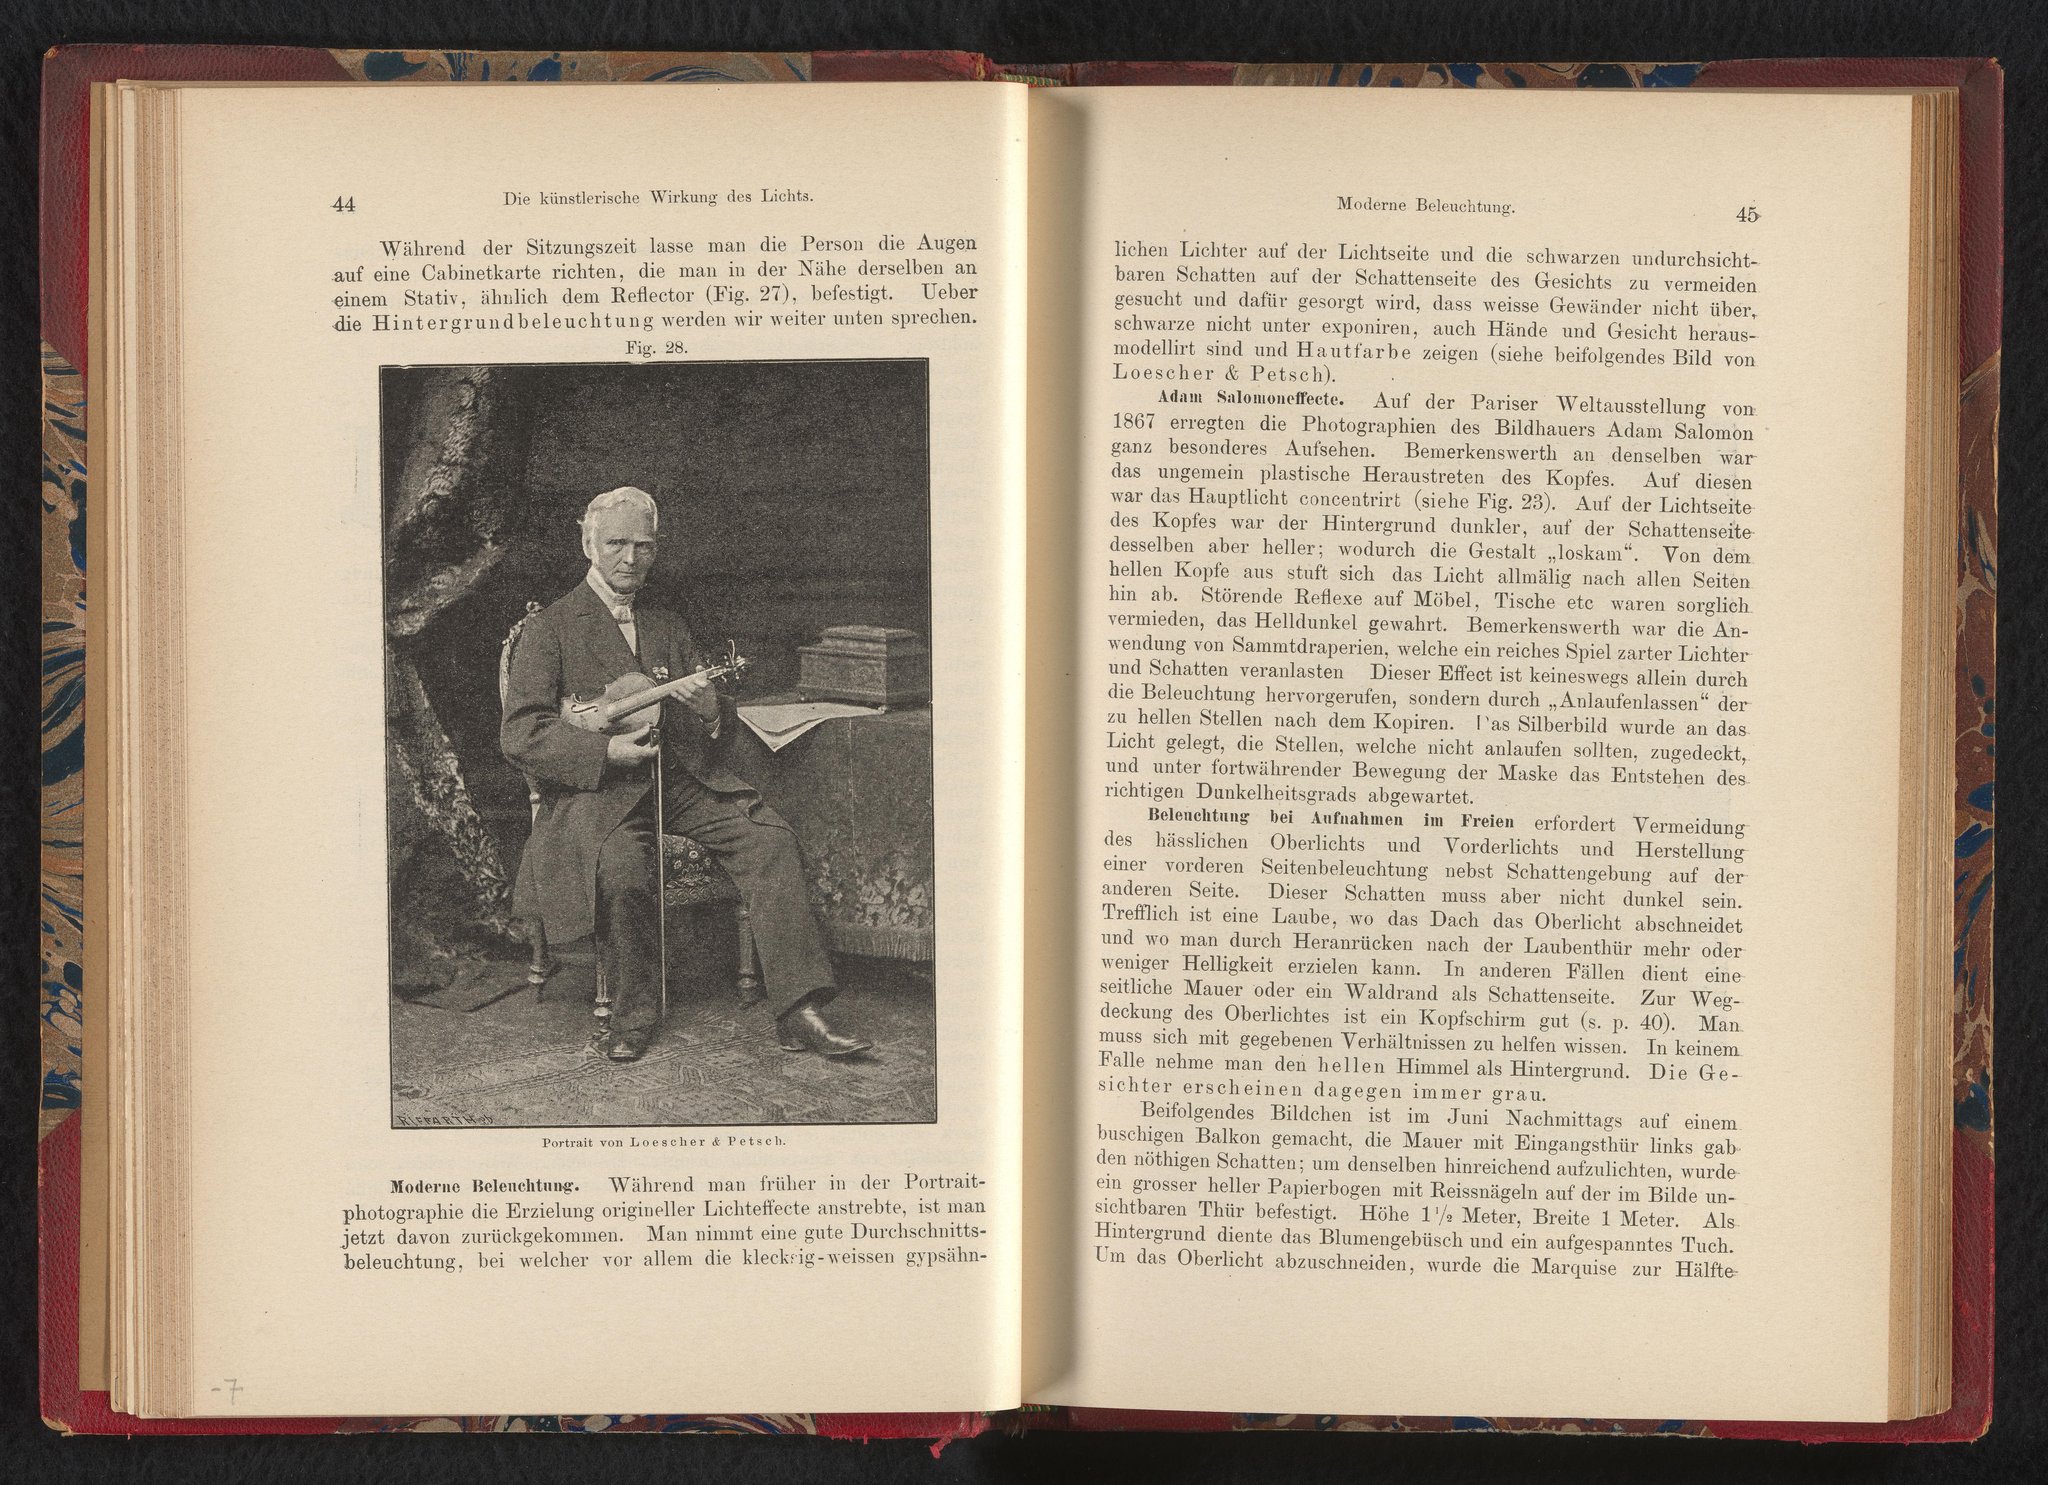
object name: photomechanical print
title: Portret van een oude man met een viool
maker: heinrich riffarth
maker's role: printer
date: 1886-1891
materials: paper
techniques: autotype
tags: old man, viola, violoncello; double bass